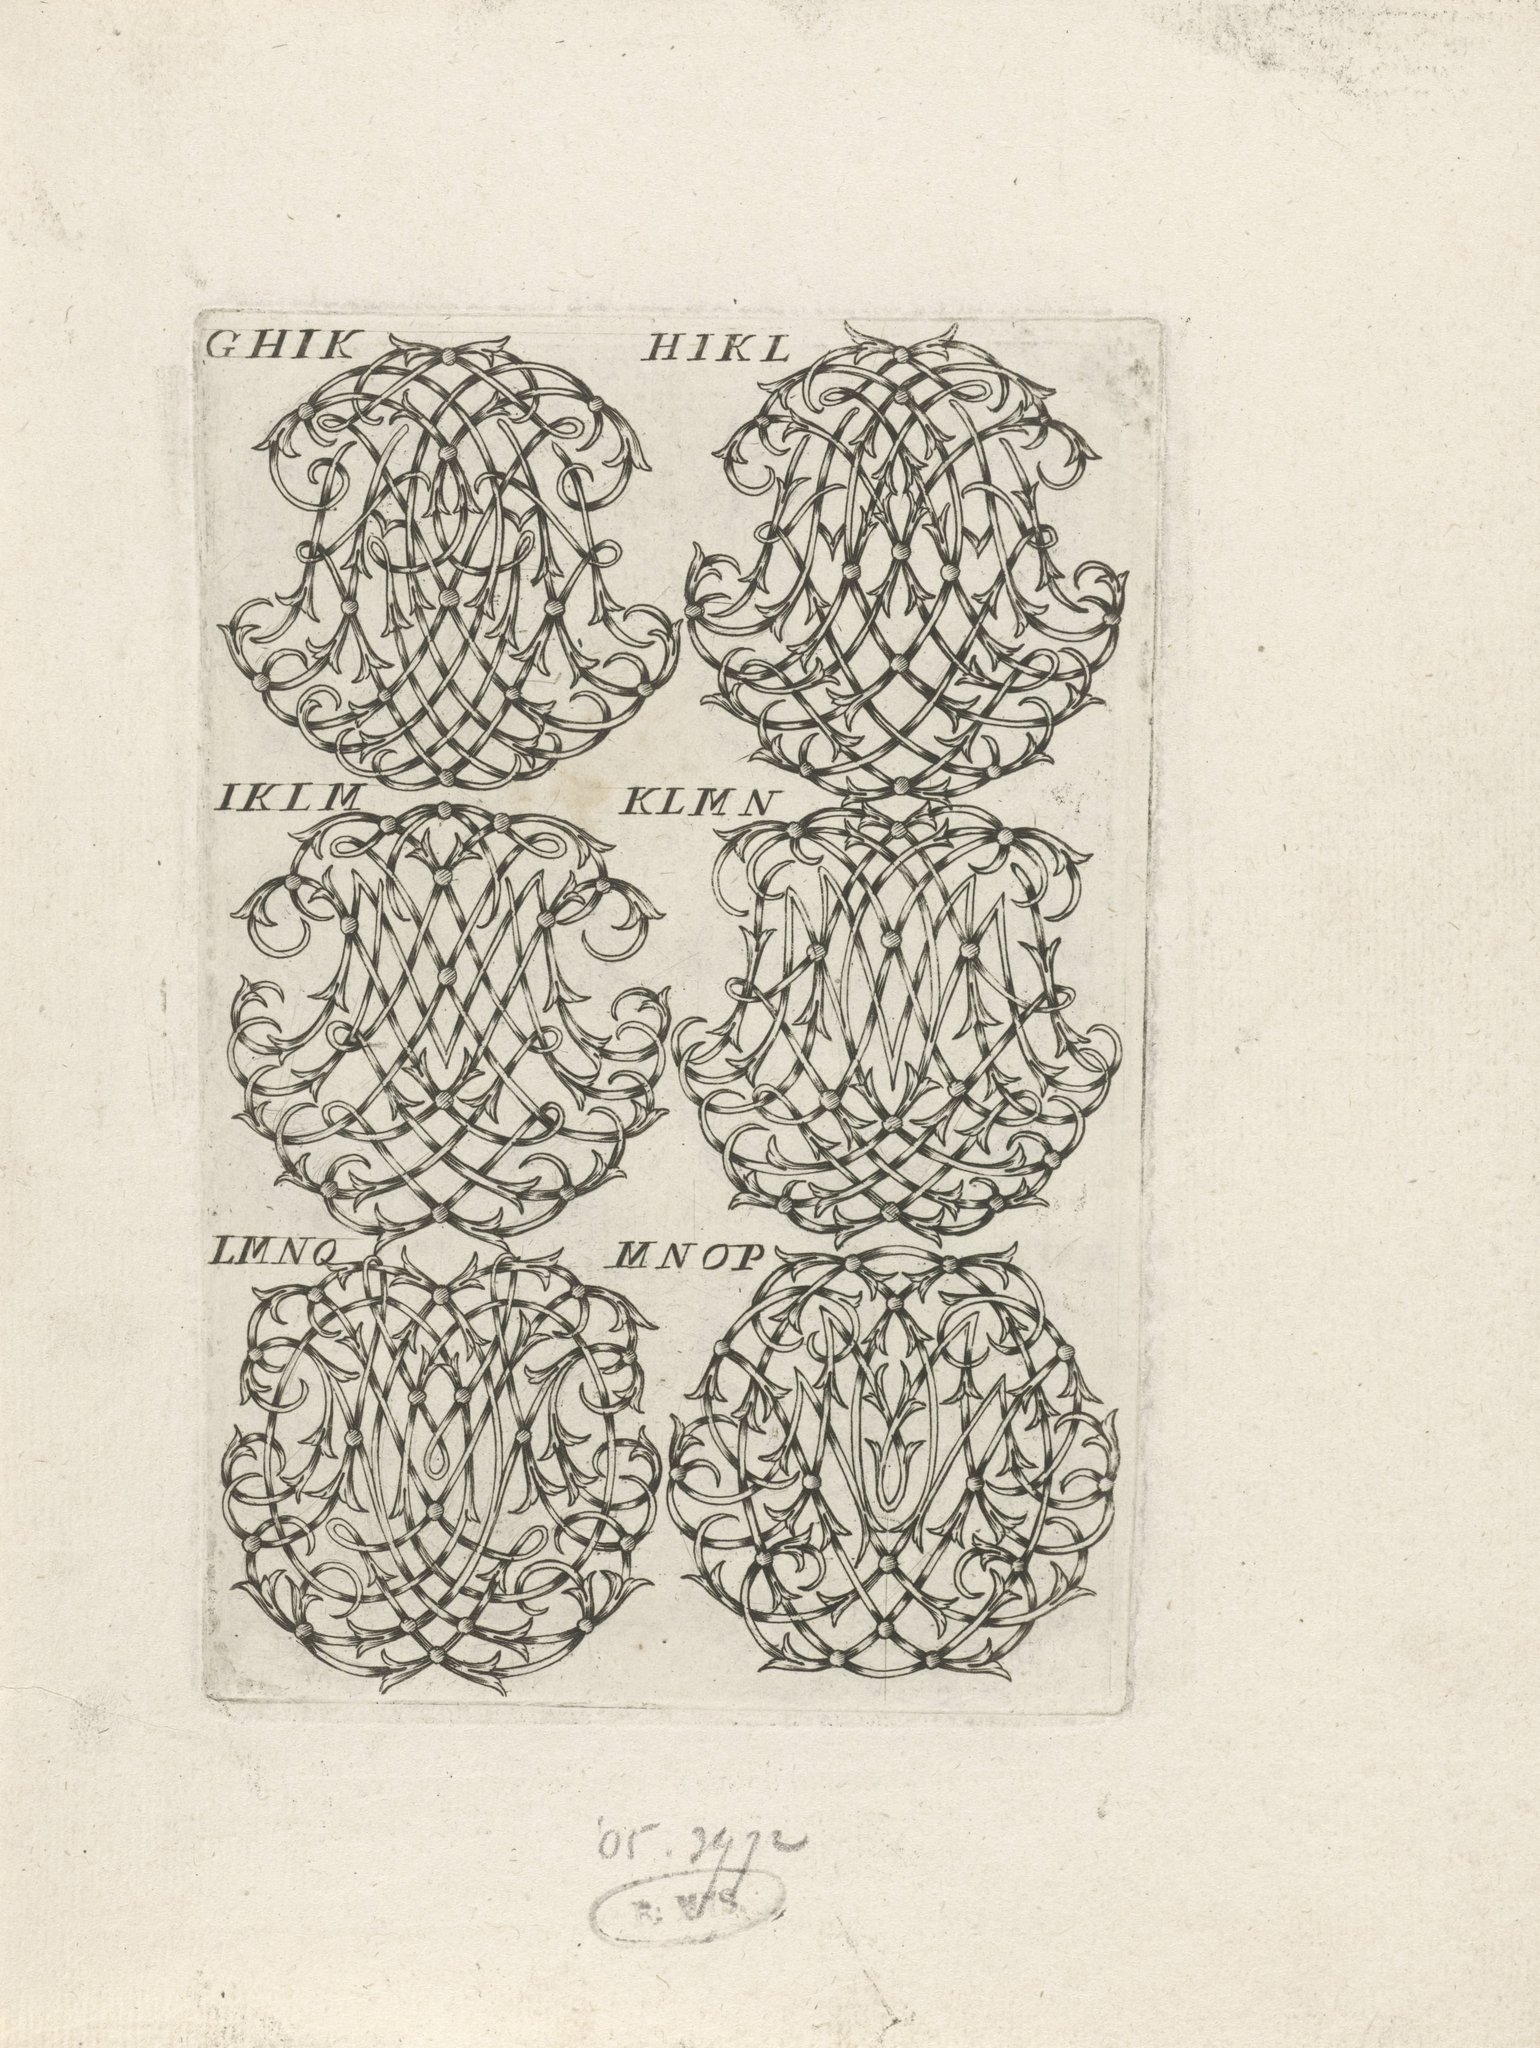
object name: ornament print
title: Zes grote monogrammen (NOPQ-STVX)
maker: daniel de lafeuille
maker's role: print maker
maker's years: 1640-1709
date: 1690-1691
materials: paper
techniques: engraving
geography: amsterdam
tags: letters, alphabet, script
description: Uit serie van 29 deels genummerde bladen met cijfermonogrammen.